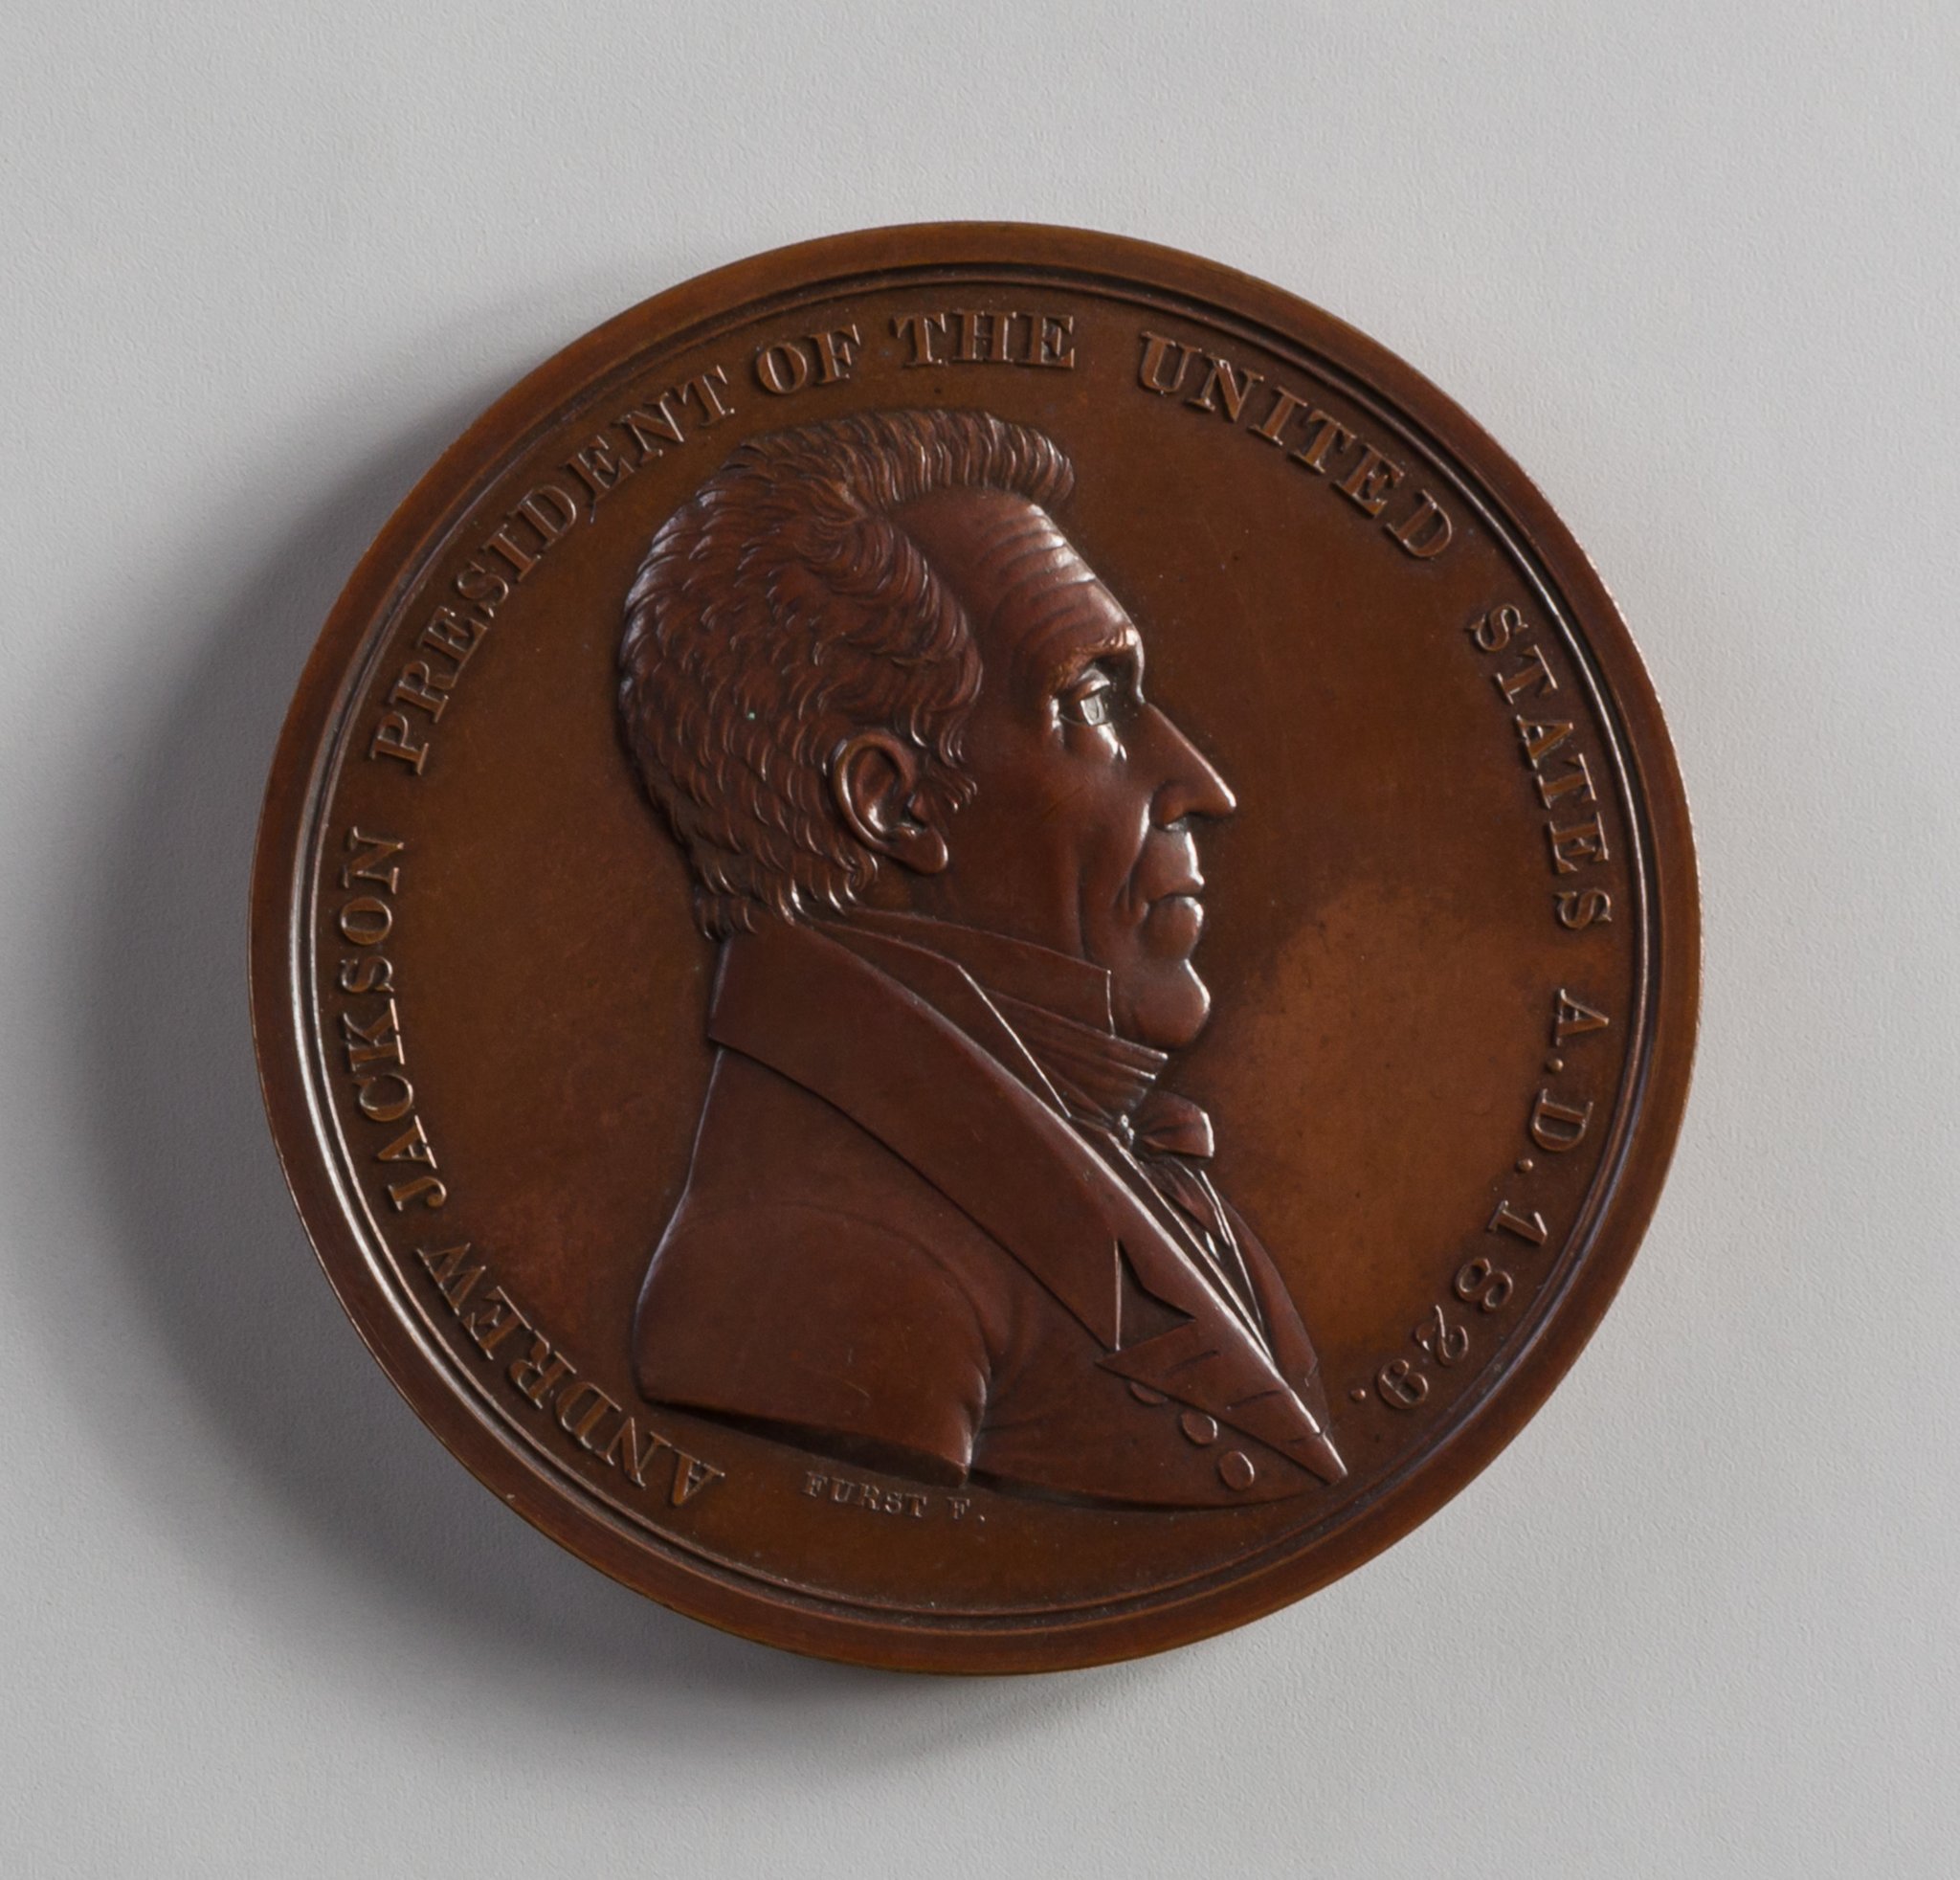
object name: medal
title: Medal of Andrew Jackson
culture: american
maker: moritz fürst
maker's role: maker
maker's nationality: hungarian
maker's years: 1782-1882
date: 1829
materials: bronze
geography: united states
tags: men,profiles